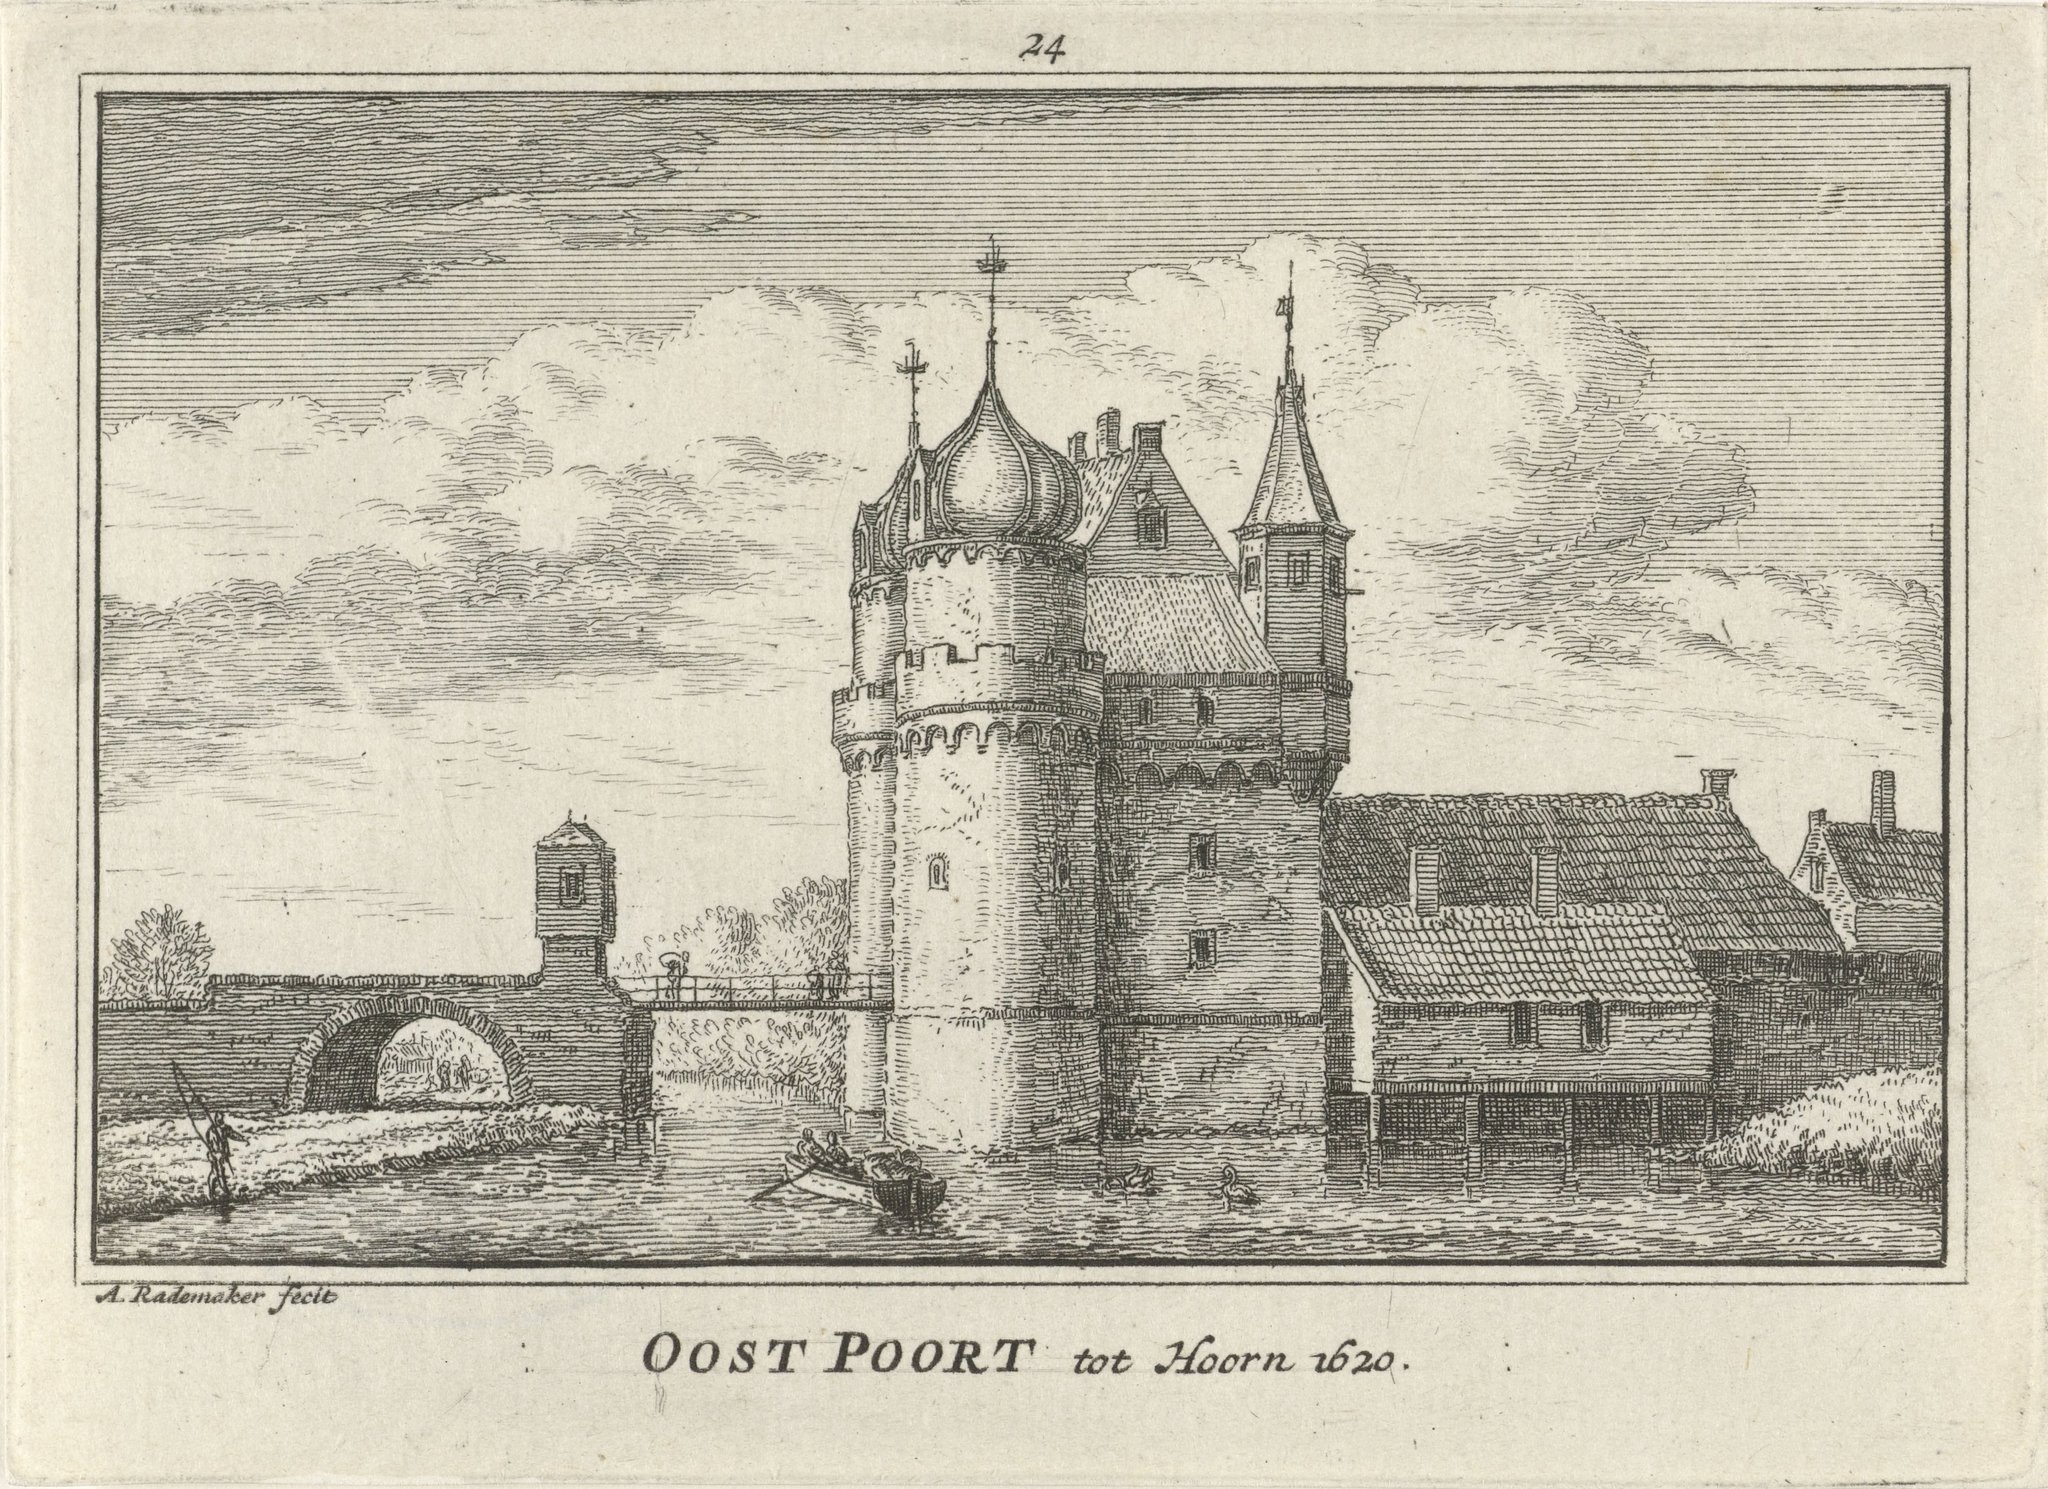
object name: print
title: Gezicht op de Oosterpoort te Hoorn, 1620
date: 1727-1733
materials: paper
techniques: etching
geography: amsterdam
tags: rowing-boat, canoe, etc., bridge, city-gate, fisherman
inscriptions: collector's mark: Lugt 2228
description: Illustratie uit: Abraham Rademaker, Matthaeus Brouërius van Niedek, Isaac Le Long, Kabinet van Nederlandsche en Kleefsche outheden en (...) voorname stads- en landgebouwen, Willem Barents en Antoni Schoonenburg: Amsterdam, 1727-1733, ill. nr. 24.